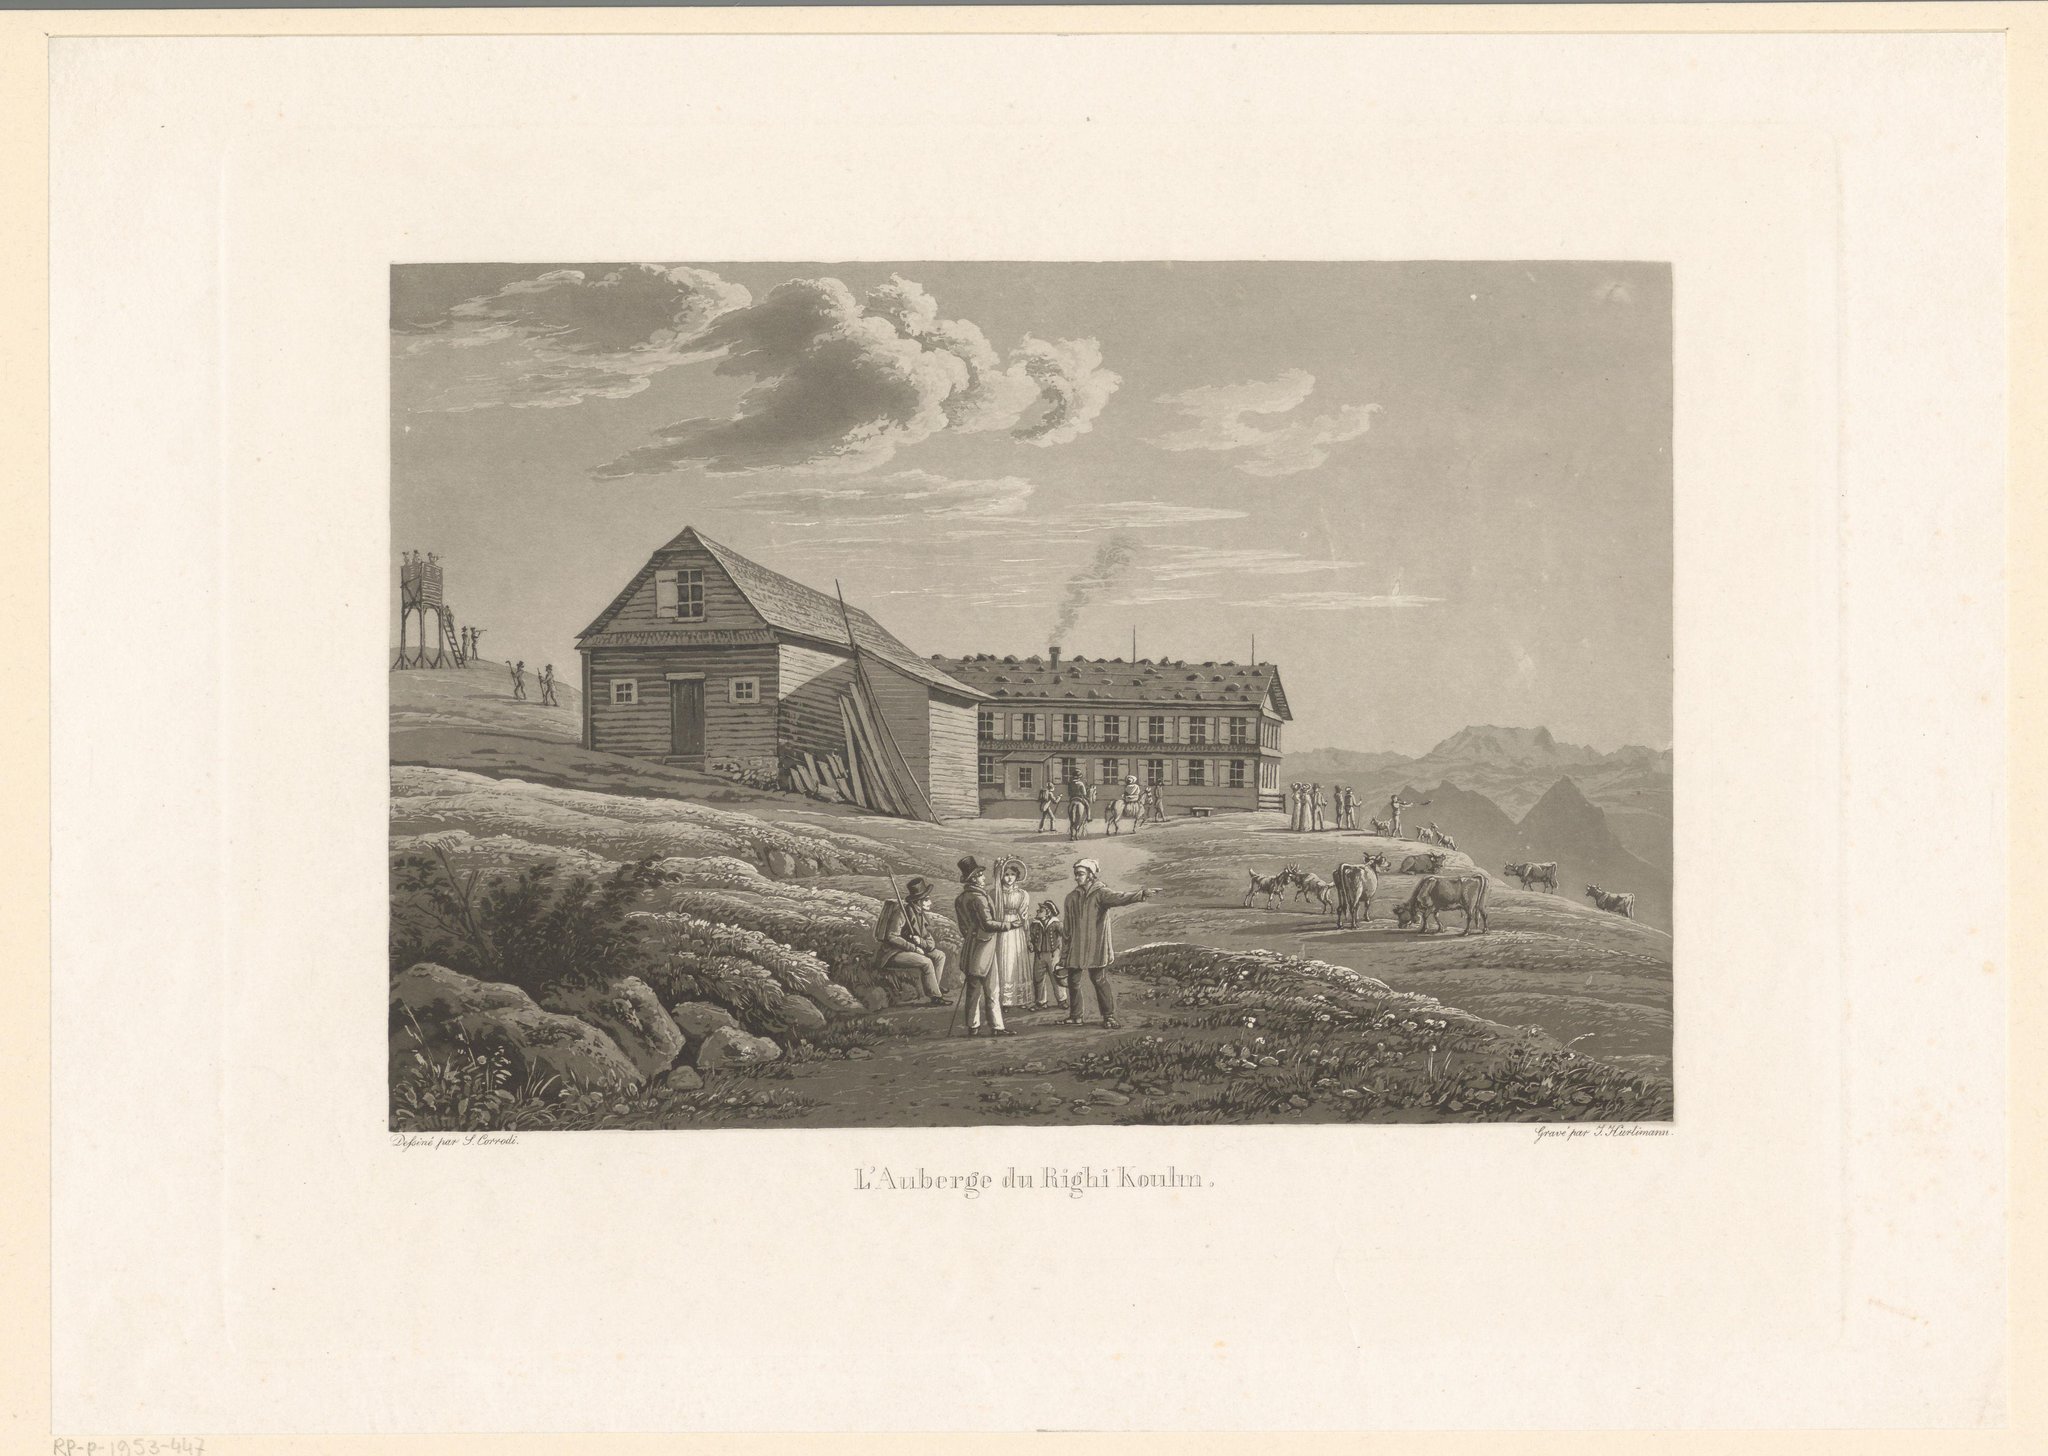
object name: print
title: L'Auberge du Righi Koulm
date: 1803-1850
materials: paper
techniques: aquatint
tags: sightseeing, meadow, pasture - hh - ideal landscapes, cow, walking, hiking (recreation), goat, hotel, hostelry, inn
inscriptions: collector's mark: Lugt 2760, collector's mark: Lugt 2228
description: Gezicht op de herberg enkele meters onder de top van de Rigi in de Zwitserse Alpen, met wandelaars, berggeiten en koeien.